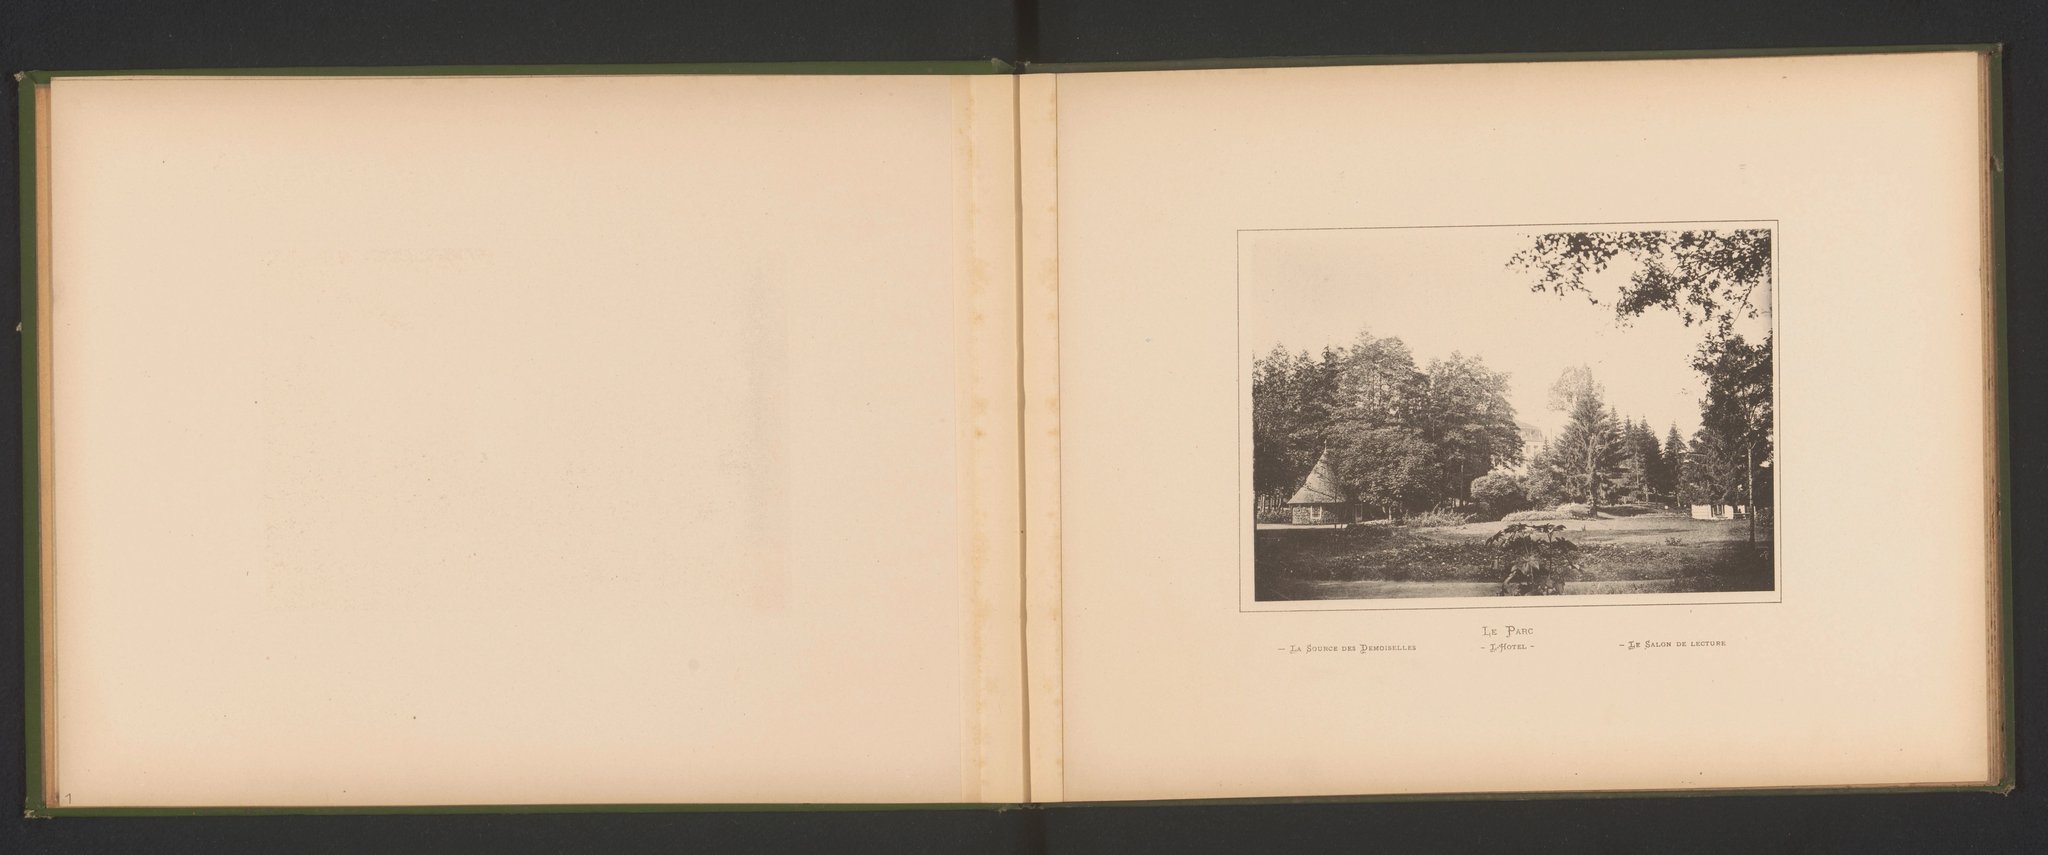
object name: photomechanical print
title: Gezicht op het park in Vittel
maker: Anonymous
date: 1885-1890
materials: paper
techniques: photograph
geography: vittel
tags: park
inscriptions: inscription: ‘- La Source des Demoiselles - L'Hotel - - Le Salon de lecture’